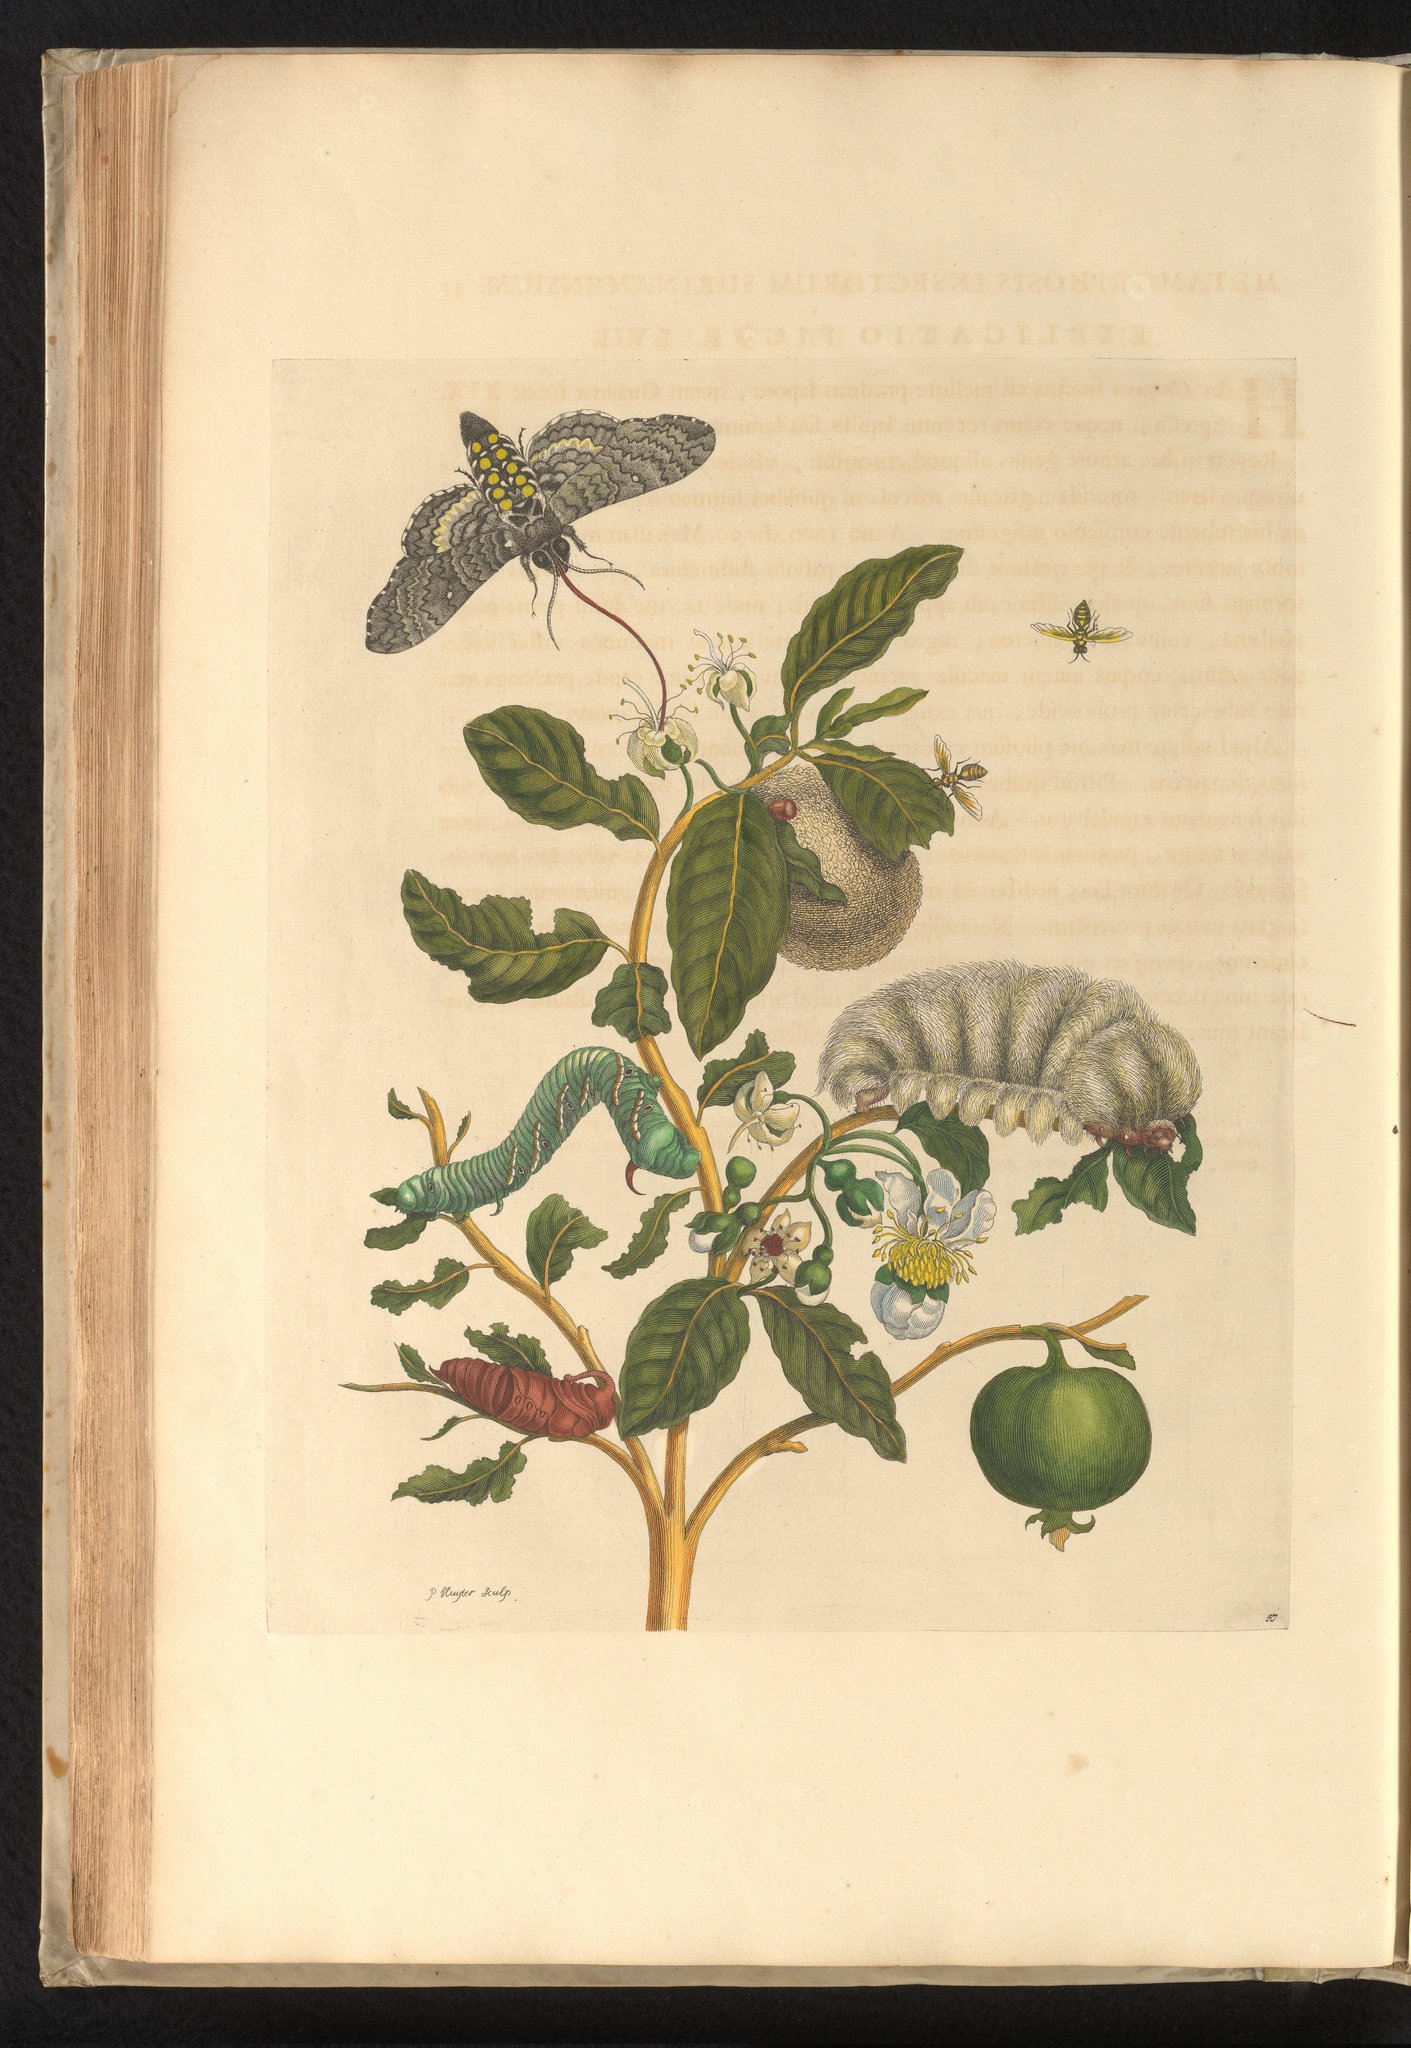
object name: print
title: Guave (Psidium guajava) met nachtvlinder, groene en witte rups en andere insecten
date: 1705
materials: paper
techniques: etching, hand coloring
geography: amsterdam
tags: insects: pupa, insects: cocoon, fruits: guava, insects: moth, insects: caterpillar, insects: fly, suriname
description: Rechtsonder genummerd: 57. Prent maakt deel uit van een boek.